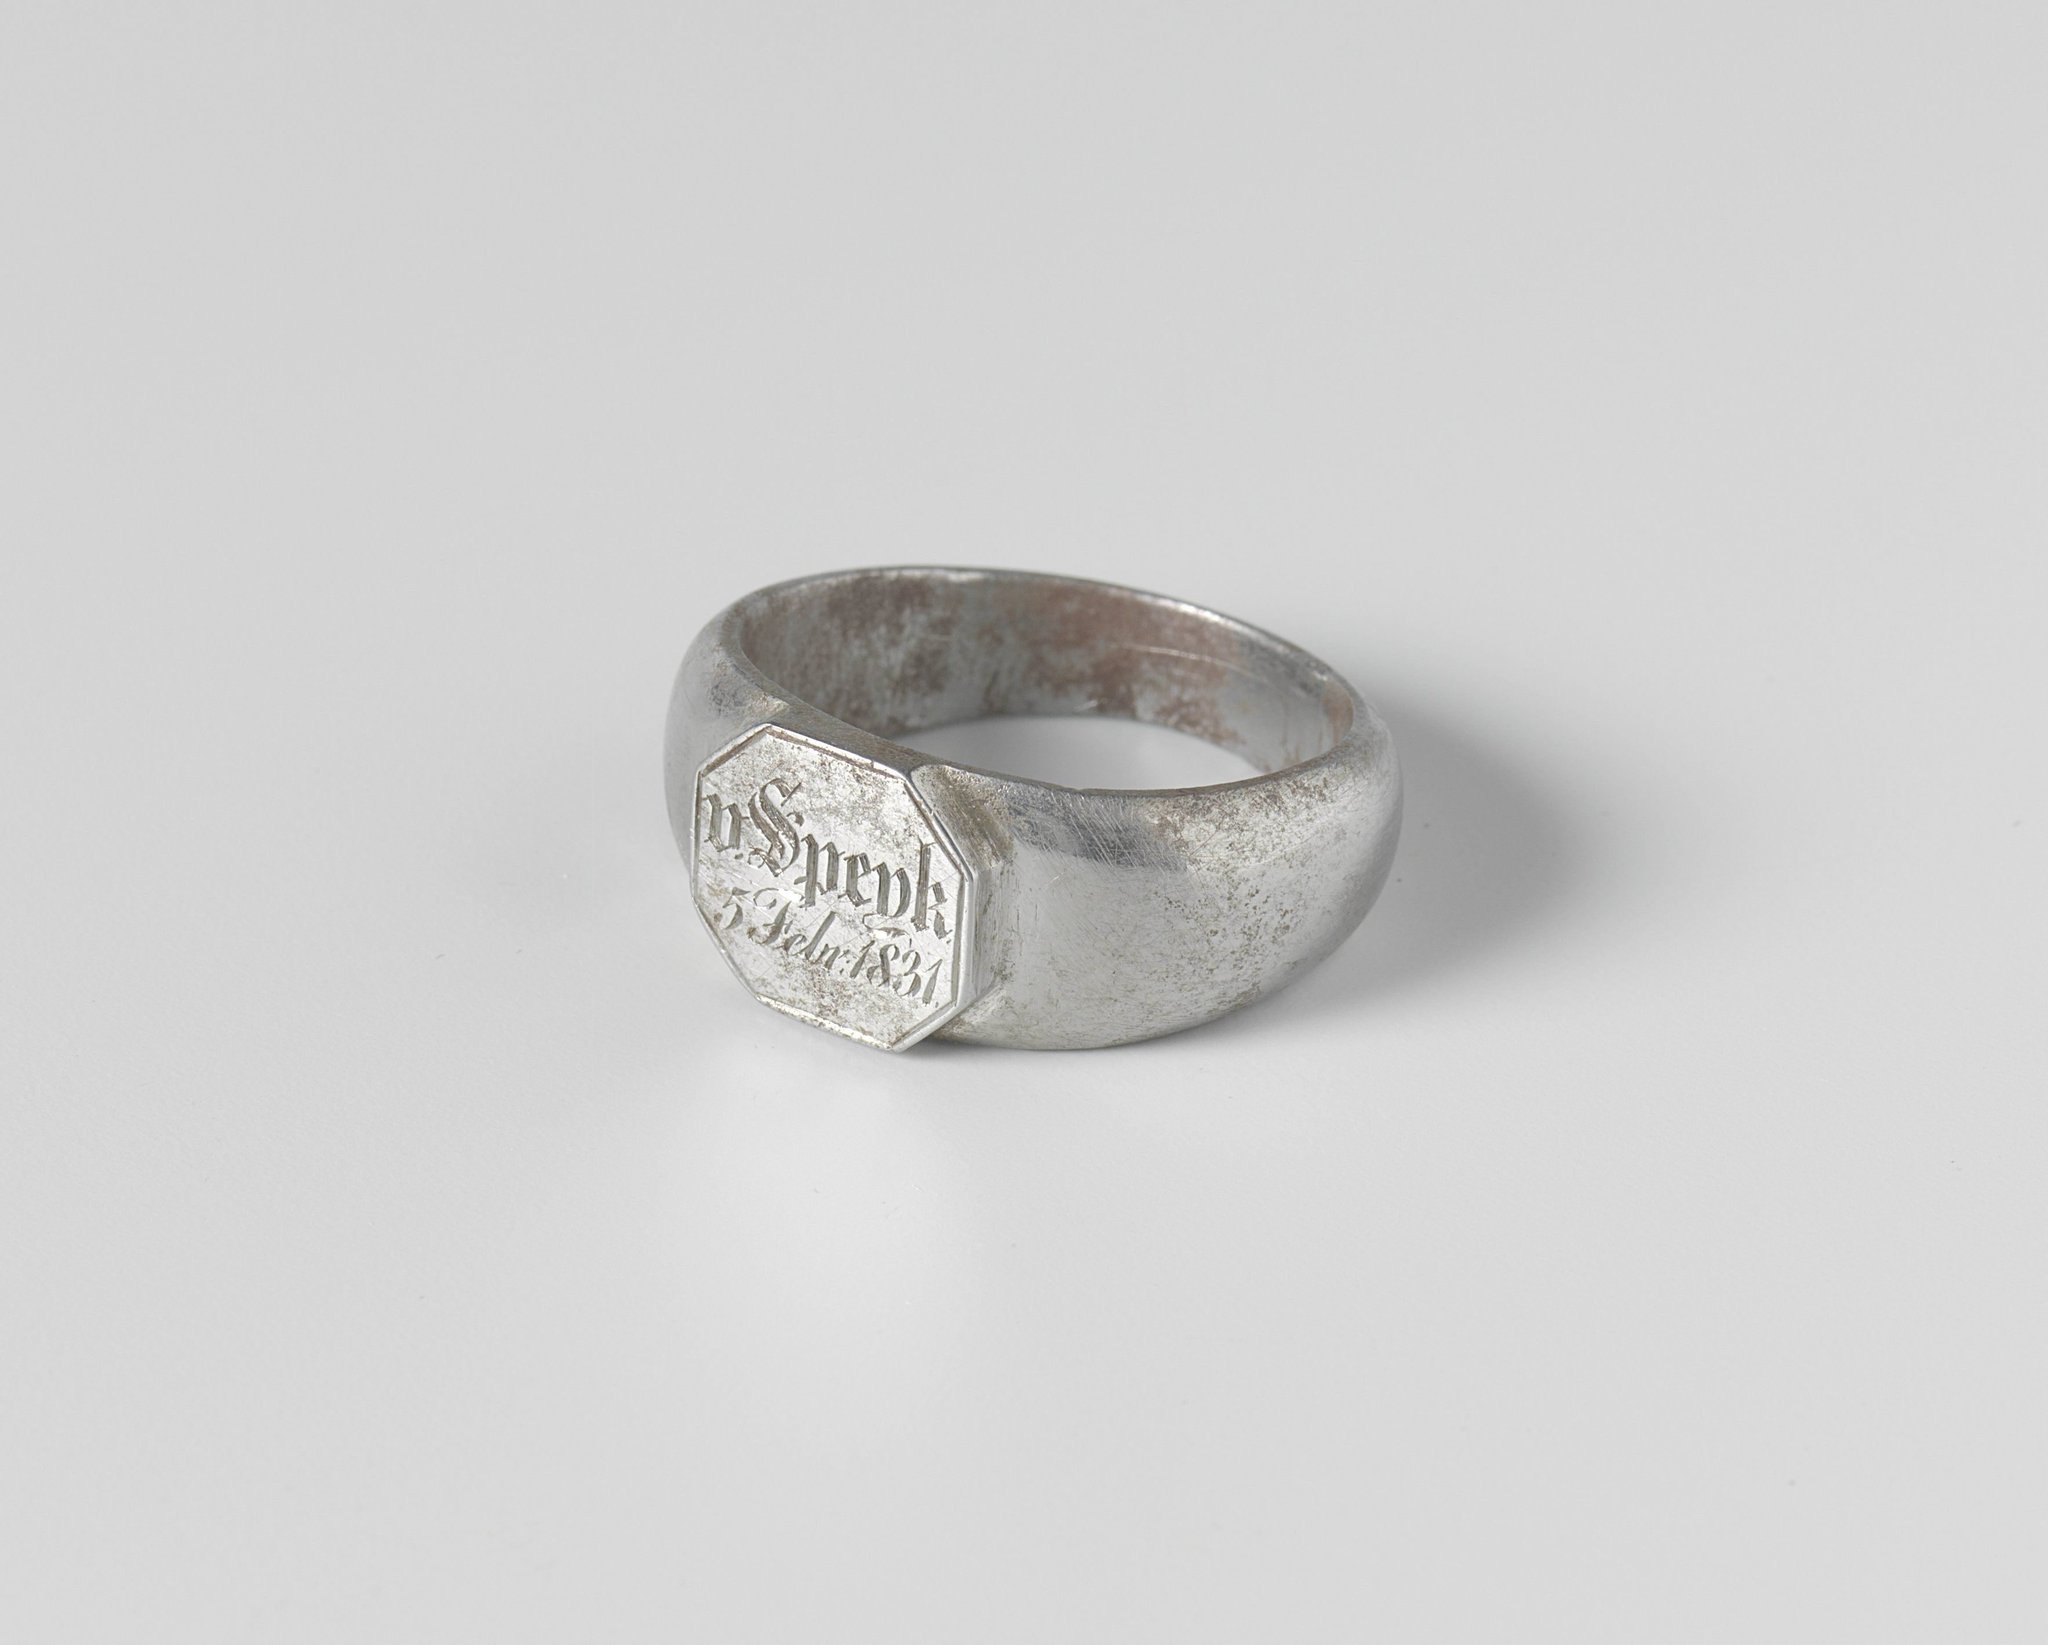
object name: ring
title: Ring van ijzer van de kanonneerboot No. 2 van J.C.J. van Speyk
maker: Anonymous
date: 1831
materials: iron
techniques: forging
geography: netherlands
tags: amsterdam, antwerp, jan van speyk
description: On 5 October 1833 the amount raised by the lottery was announced. After costs the lottery made ? 6484,98. A total of 5723 tickets had been sold and 911 prizes awarded.